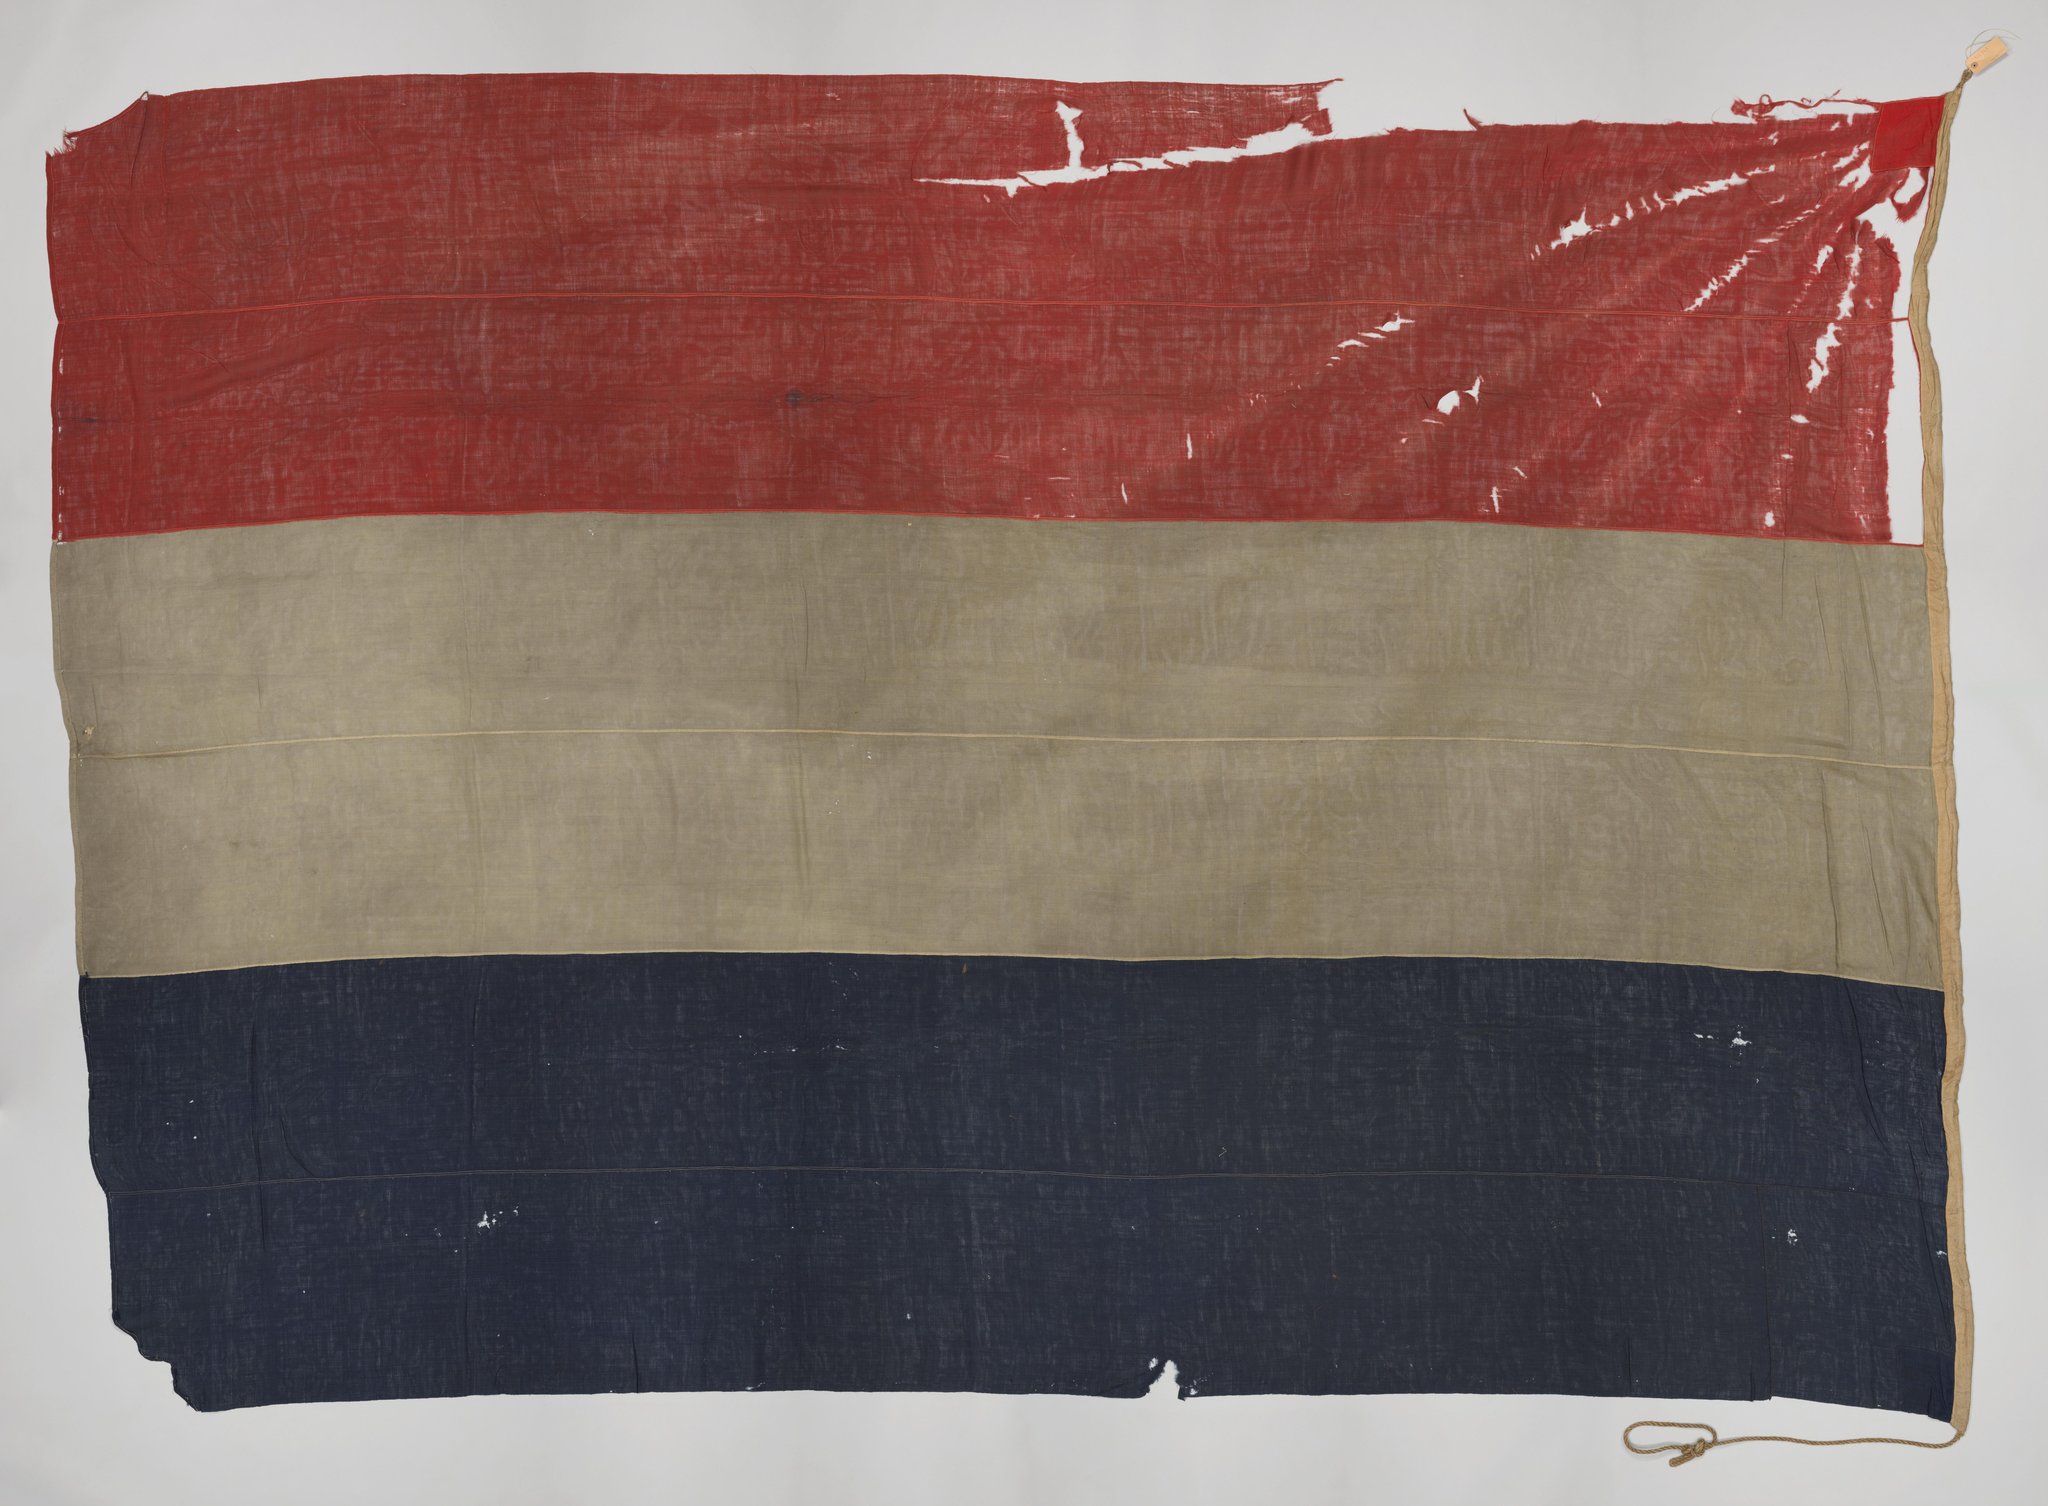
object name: ship flag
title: Scheepsvlag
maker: Anonymous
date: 1800-1890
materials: wool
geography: netherlands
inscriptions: : ‘NED.VL.6.KL’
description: Drie banen rood-wit-blauw. Opschrift: NED.VL.6.KL.